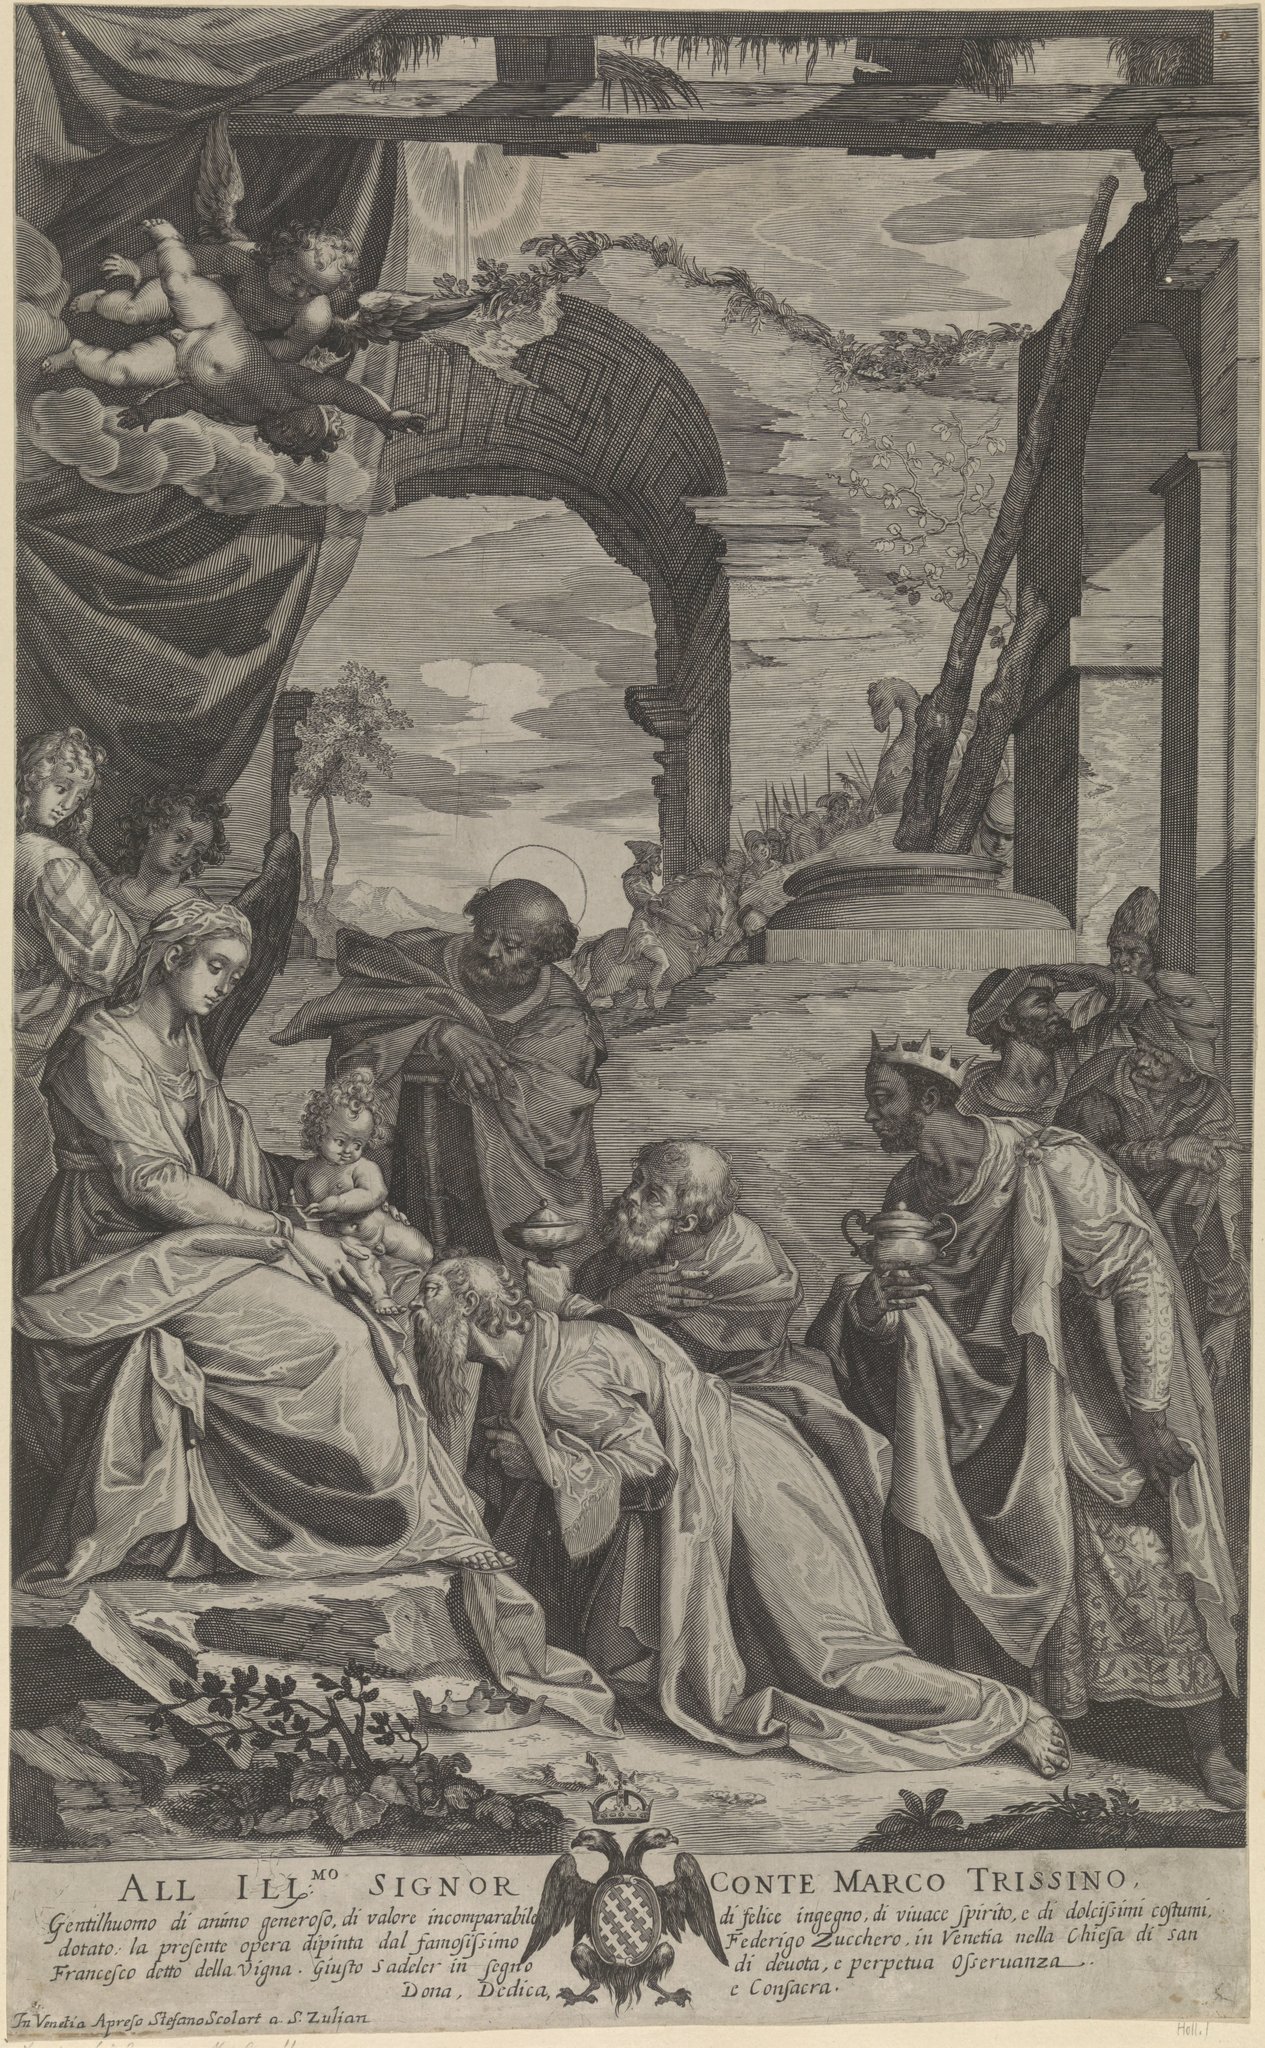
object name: print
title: Aanbidding der koningen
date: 1600-1620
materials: paper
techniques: engraving, etching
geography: venice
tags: adoration of the kings: the wise men present their gifts to the christ-child (gold, frankincense and myrrh)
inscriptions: collector's mark: Lugt 240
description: Maria en Jozef tonen het Christuskind aan de drie wijzen. De koningen knielen voor het kind en bieden het geschenken aan. De voorste koning kust zijn voeten. Aan de hemel straalt de ster die hen heeft geleid. De prent eheft een Italiaans onderschrift met een opdracht en het wapenschild van Marcus Trissinus.